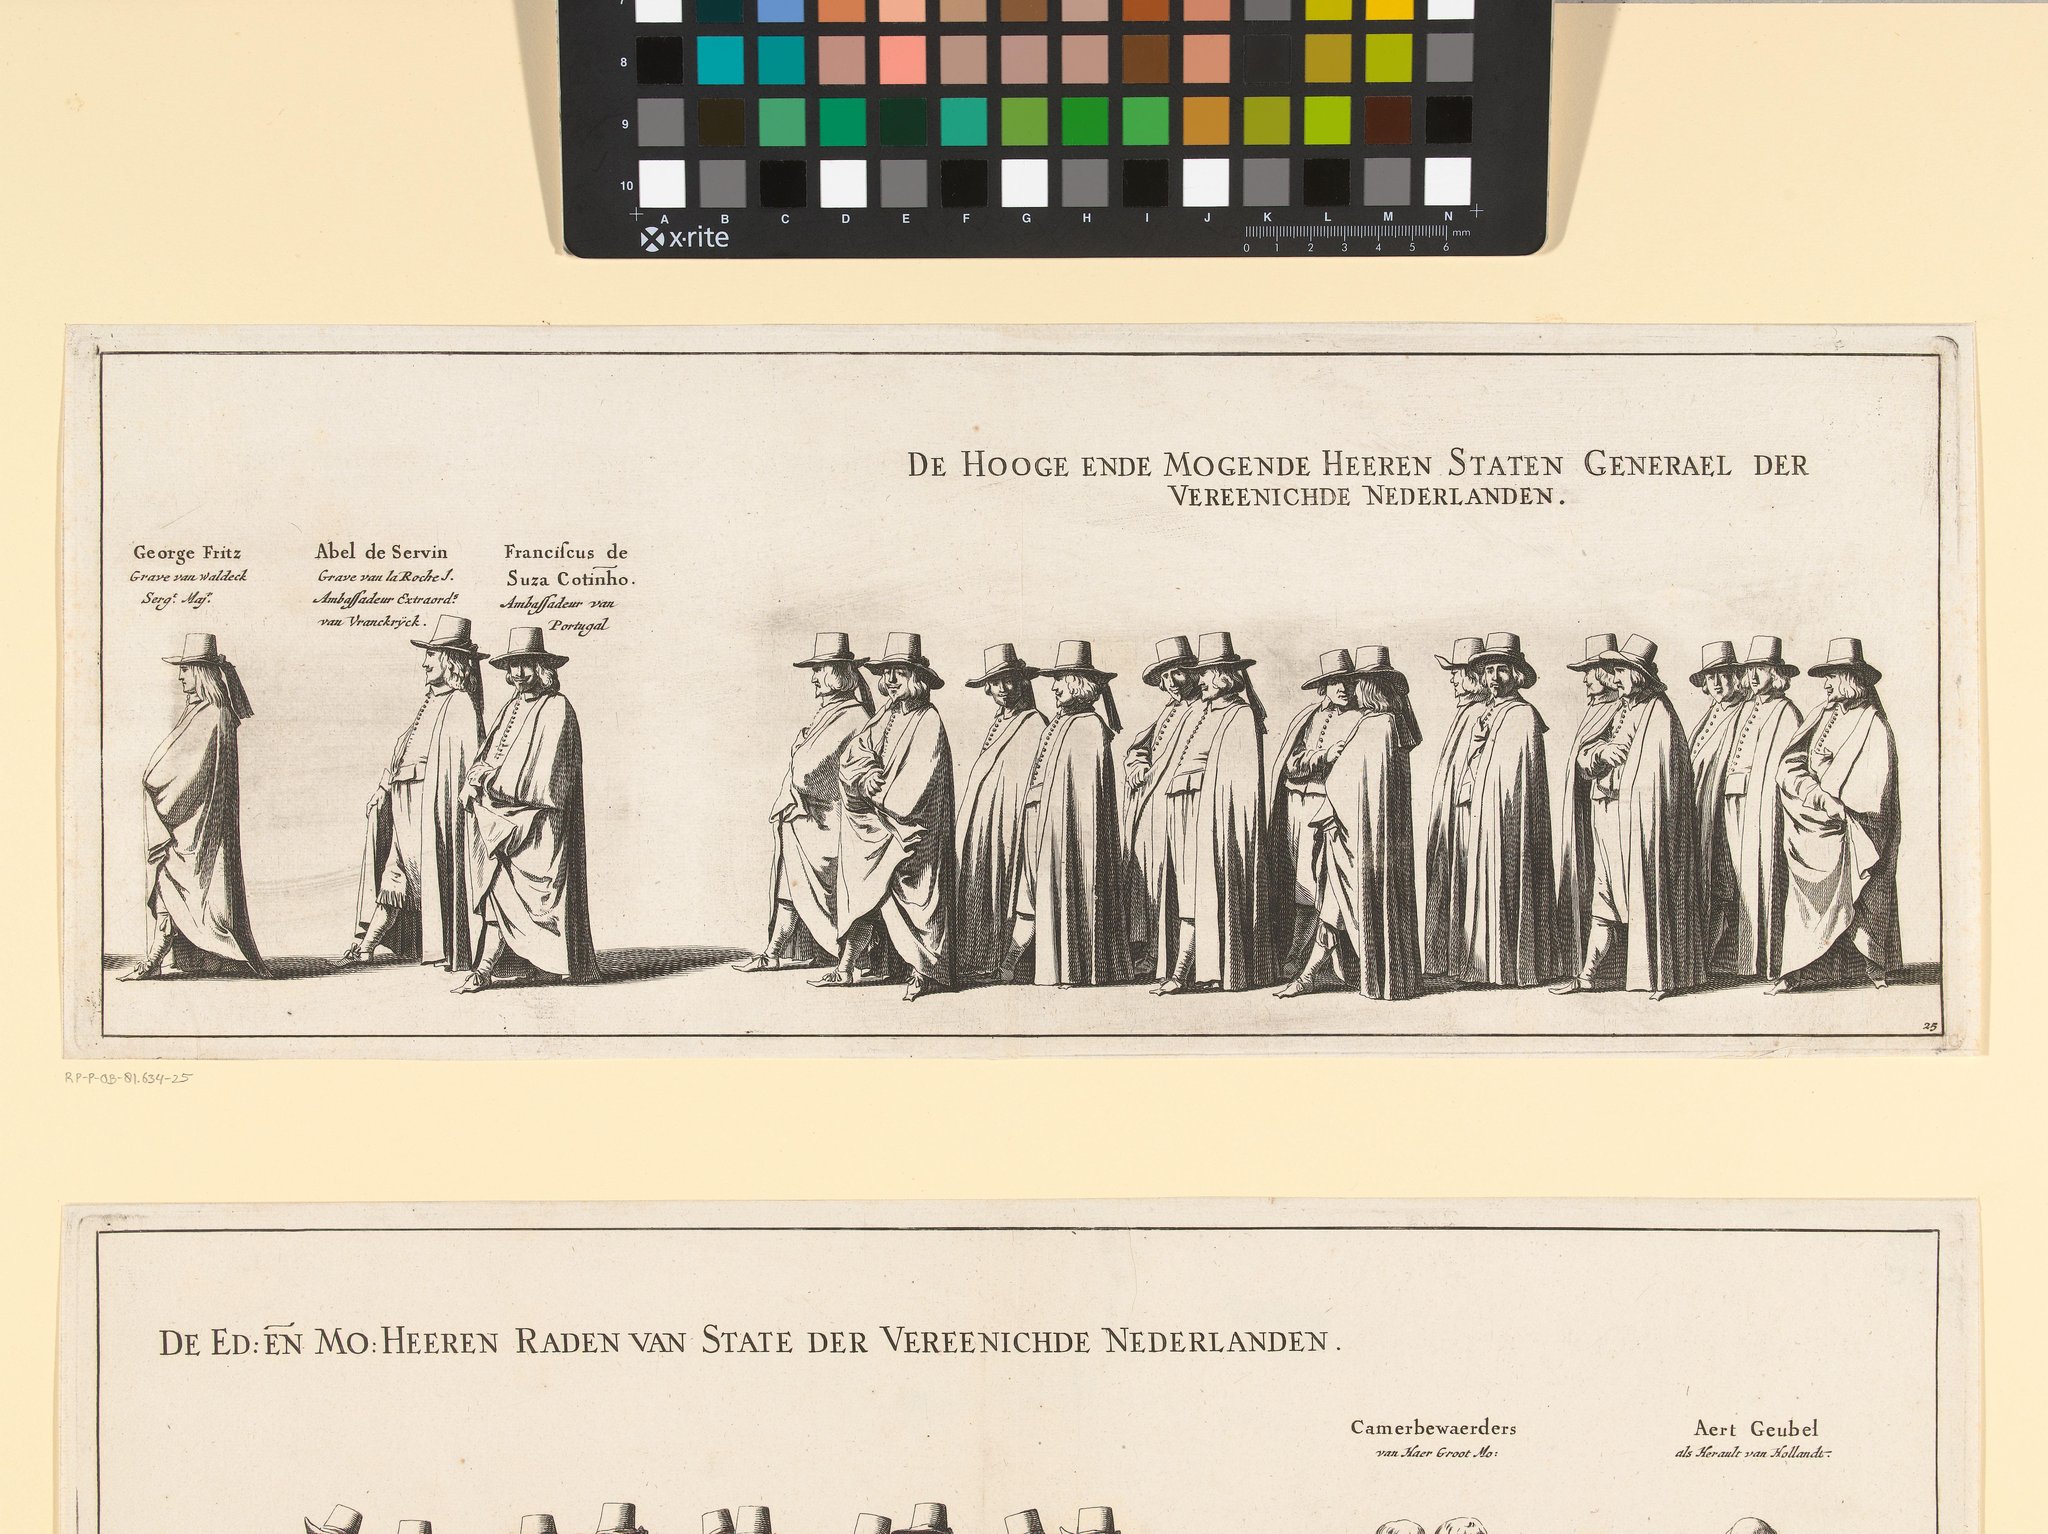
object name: print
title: Begraeffenisse van Syne Hoogheyt Frederick Henrick, by der Gratien Gods Prince van Orange, Grave van Nassau &c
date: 1647-1651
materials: paper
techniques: etching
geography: northern netherlands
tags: delft, the hague, frederick henry (prince of orange), cortege, funeral procession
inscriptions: collector's mark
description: De begrafenisstoet van stadhouder Frederik Hendrik te 's-Gravenhage op 10 mei 1647. Plaat nr. 25 met een deel van de stoet met leden van de Staten-Generaal, boven de personen staat hun functie. Onderdeel van een serie van 30 platen en 20 tekstbladen, bedoeld om aan elkaar geplakt te worden.